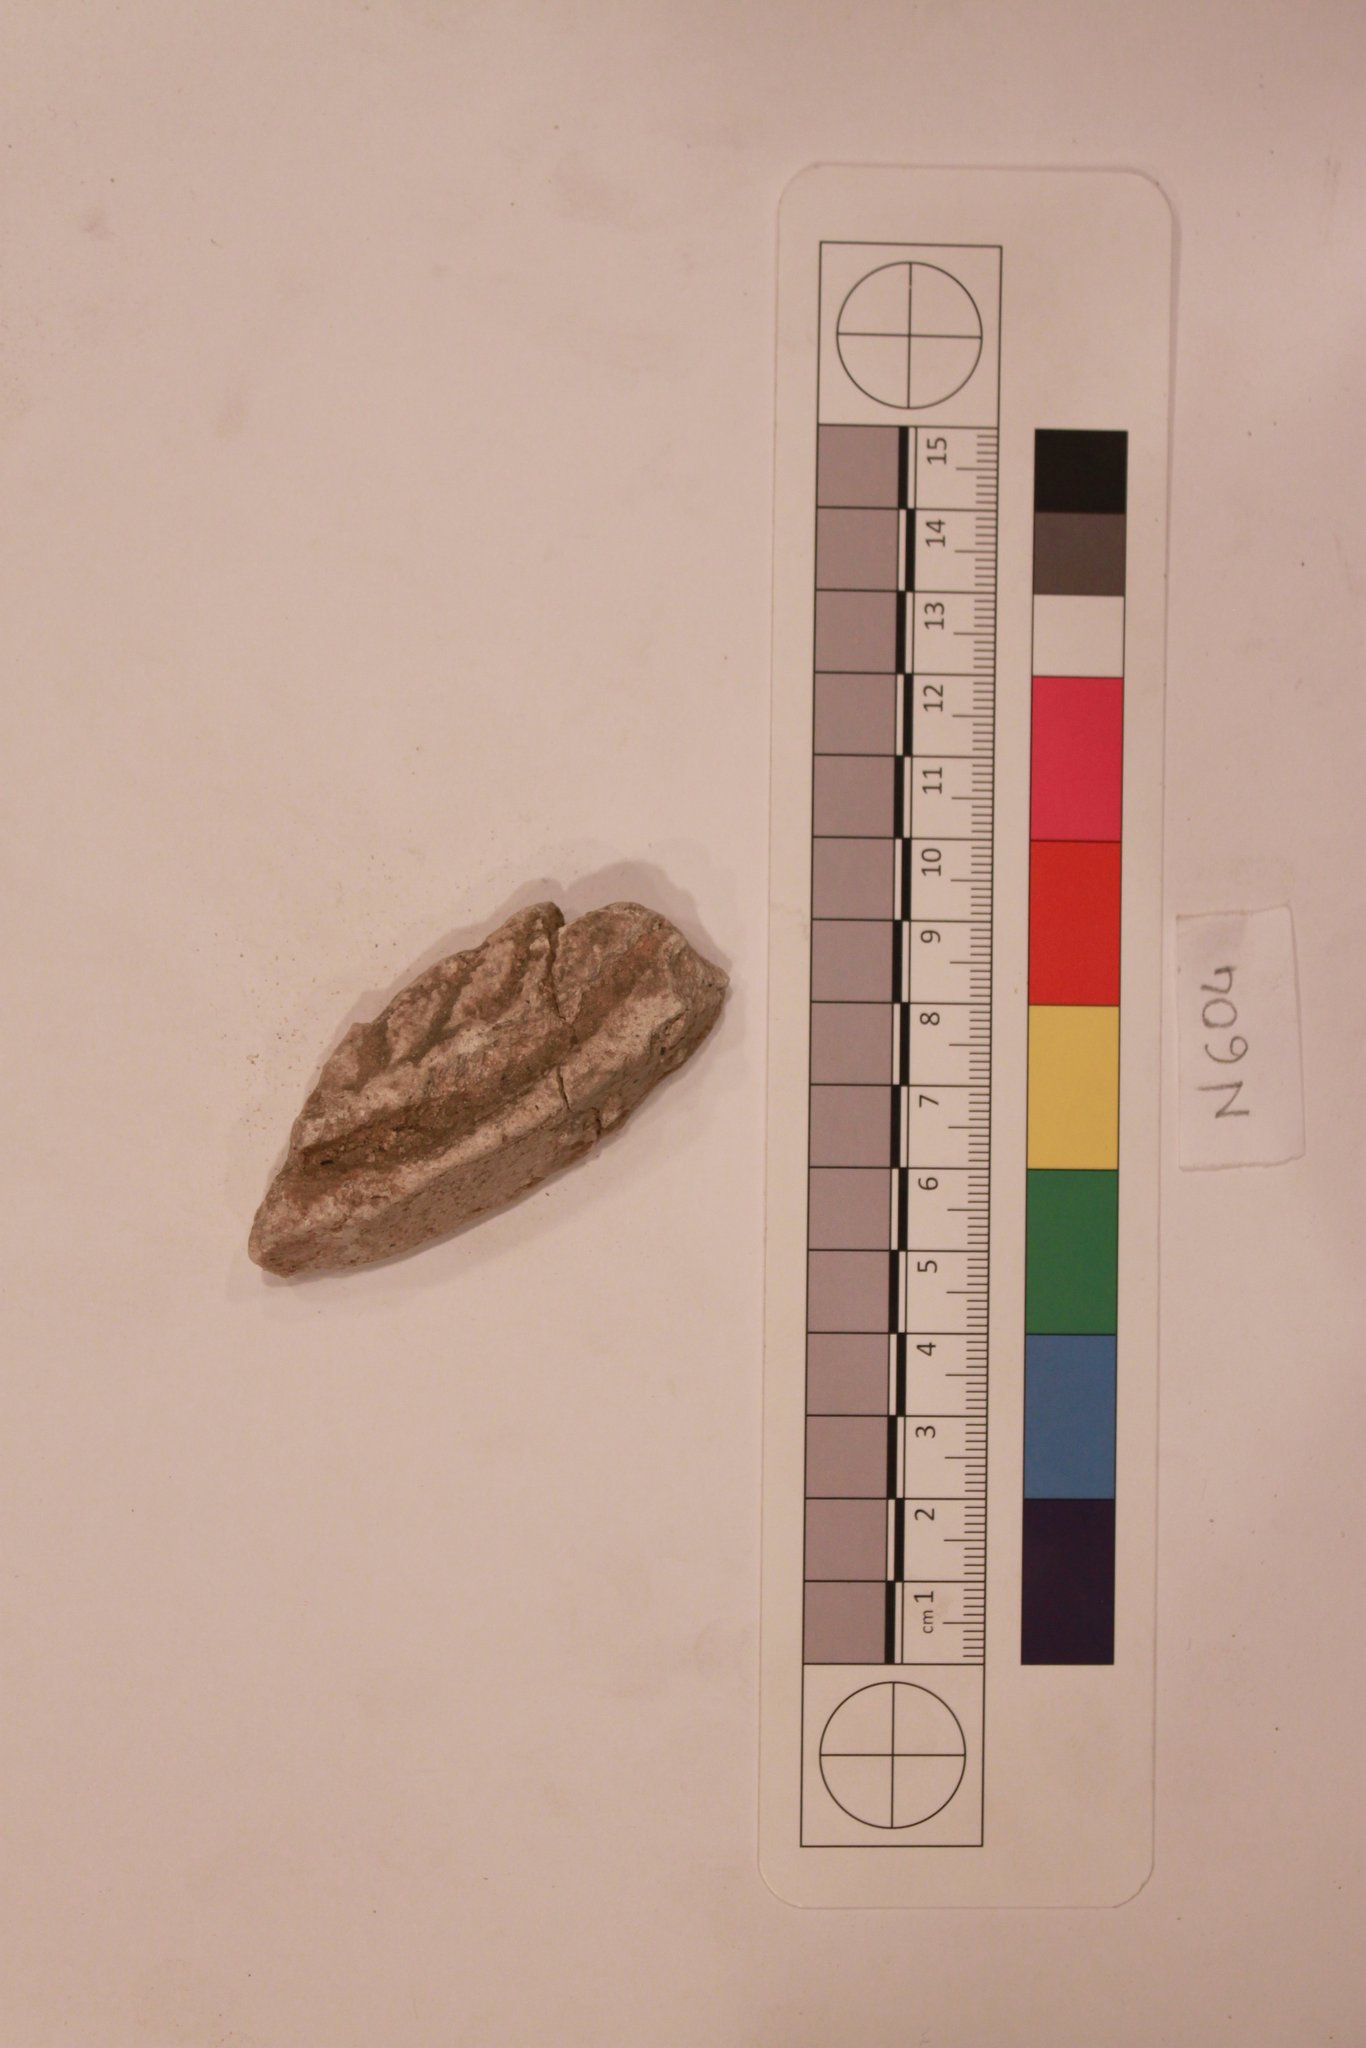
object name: fragment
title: Stucco Fragment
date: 701-1200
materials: plaster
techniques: carving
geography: iran